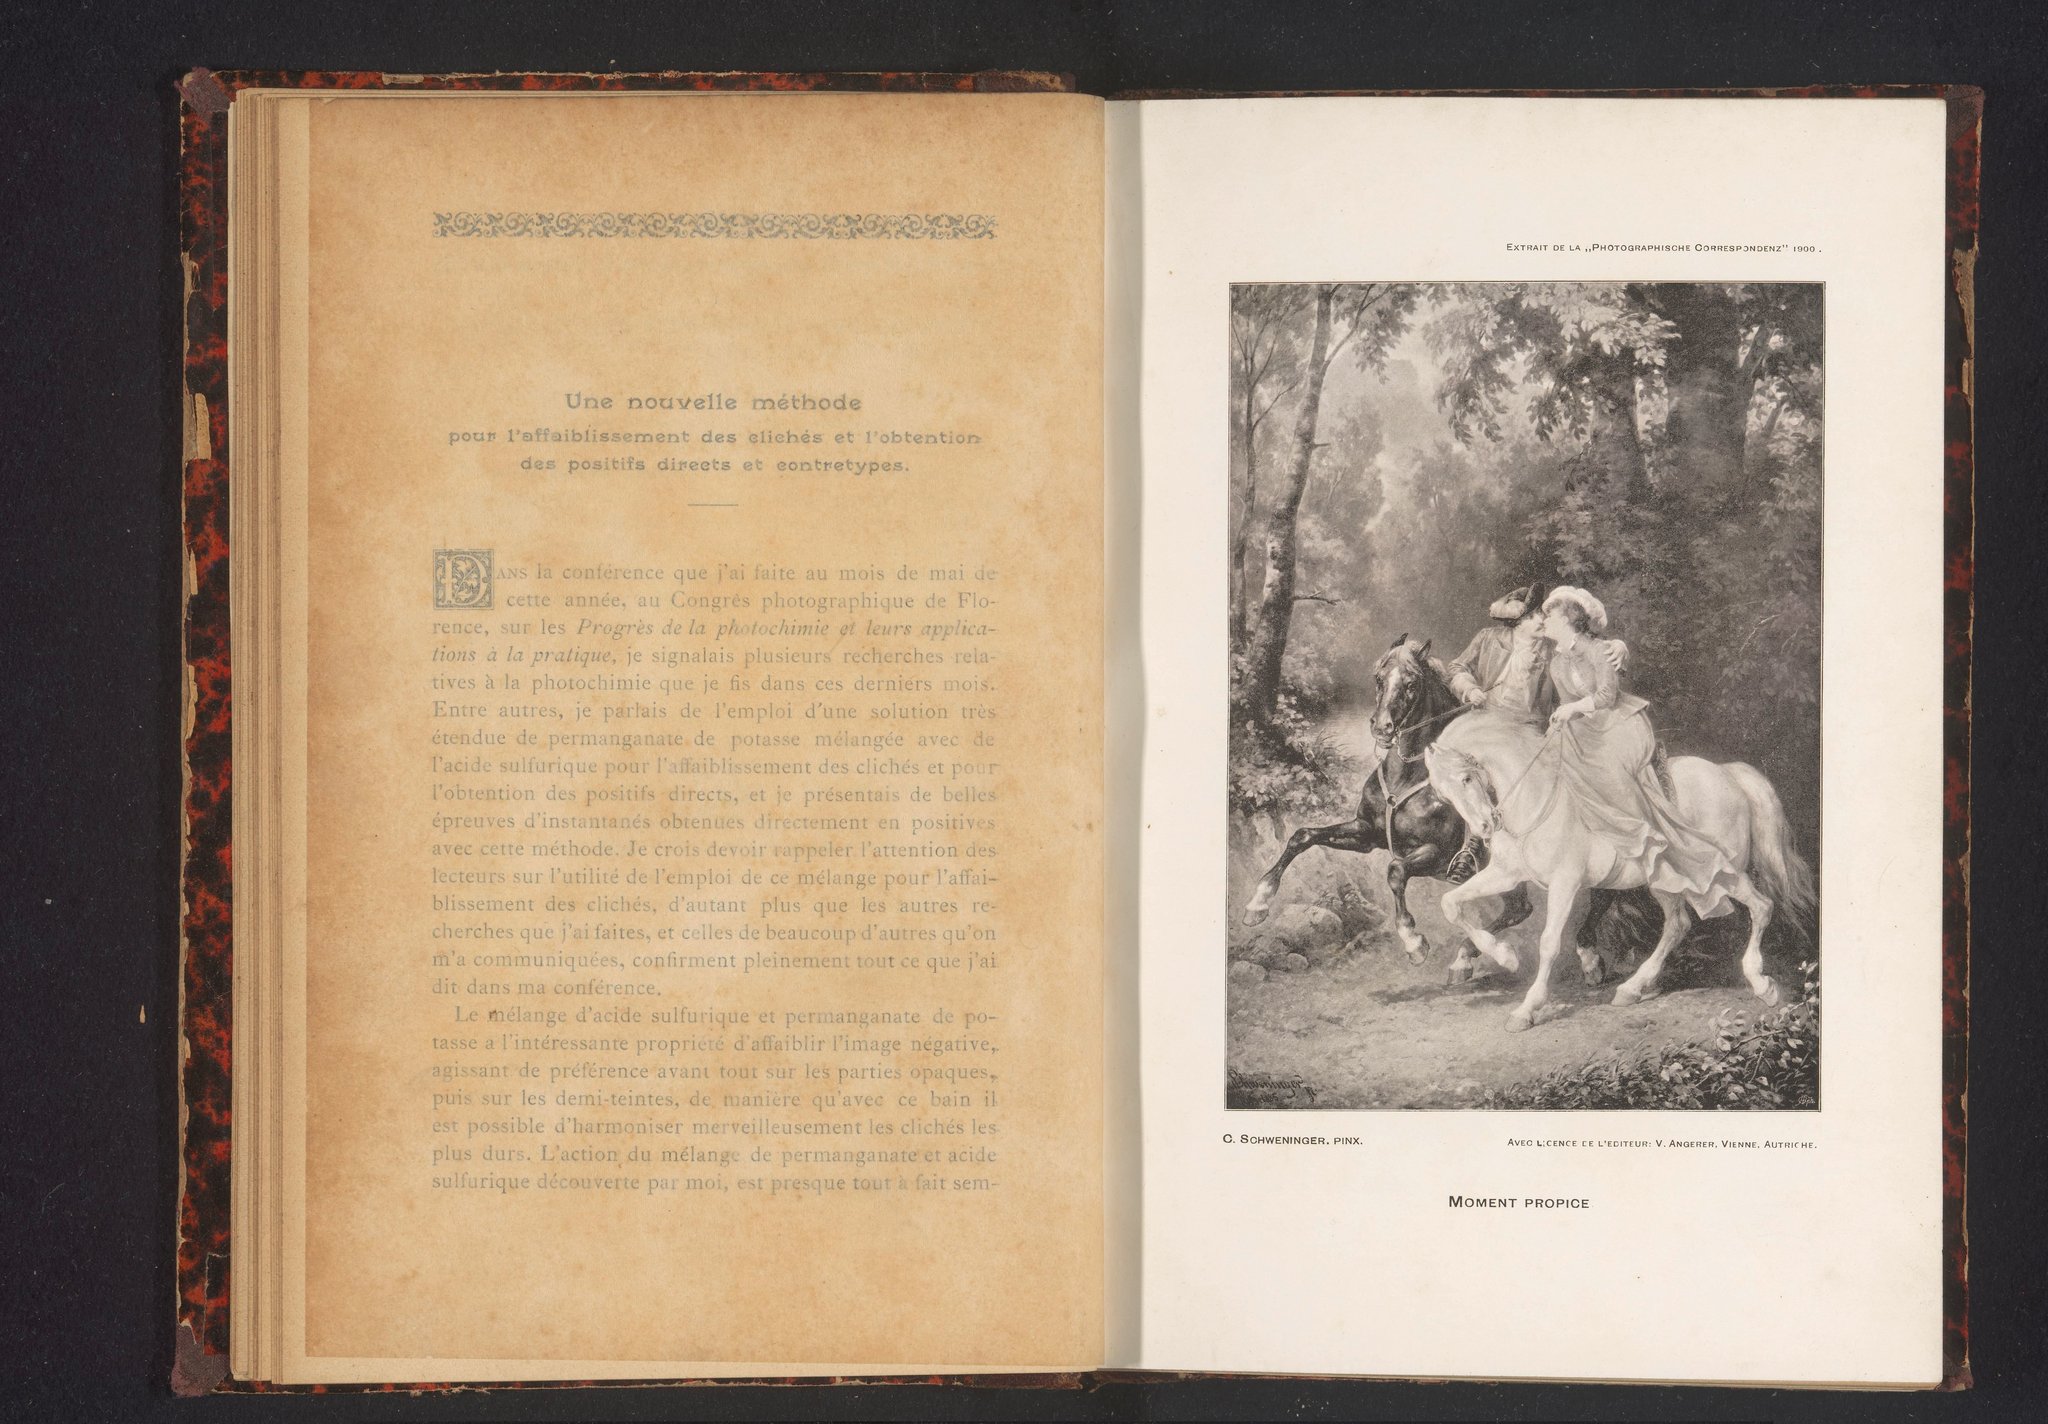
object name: page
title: Reproductie van een schilderij van kussende ruiters door Carl Schweninger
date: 1895-1900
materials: paper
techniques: autotype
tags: riding a horse, ass, or mule; rider, horseman, (lovers) kissing each other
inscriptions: inscription: ‘Extrait de la "Photographische Correspondenz" 1900’, monogram: ‘AG’